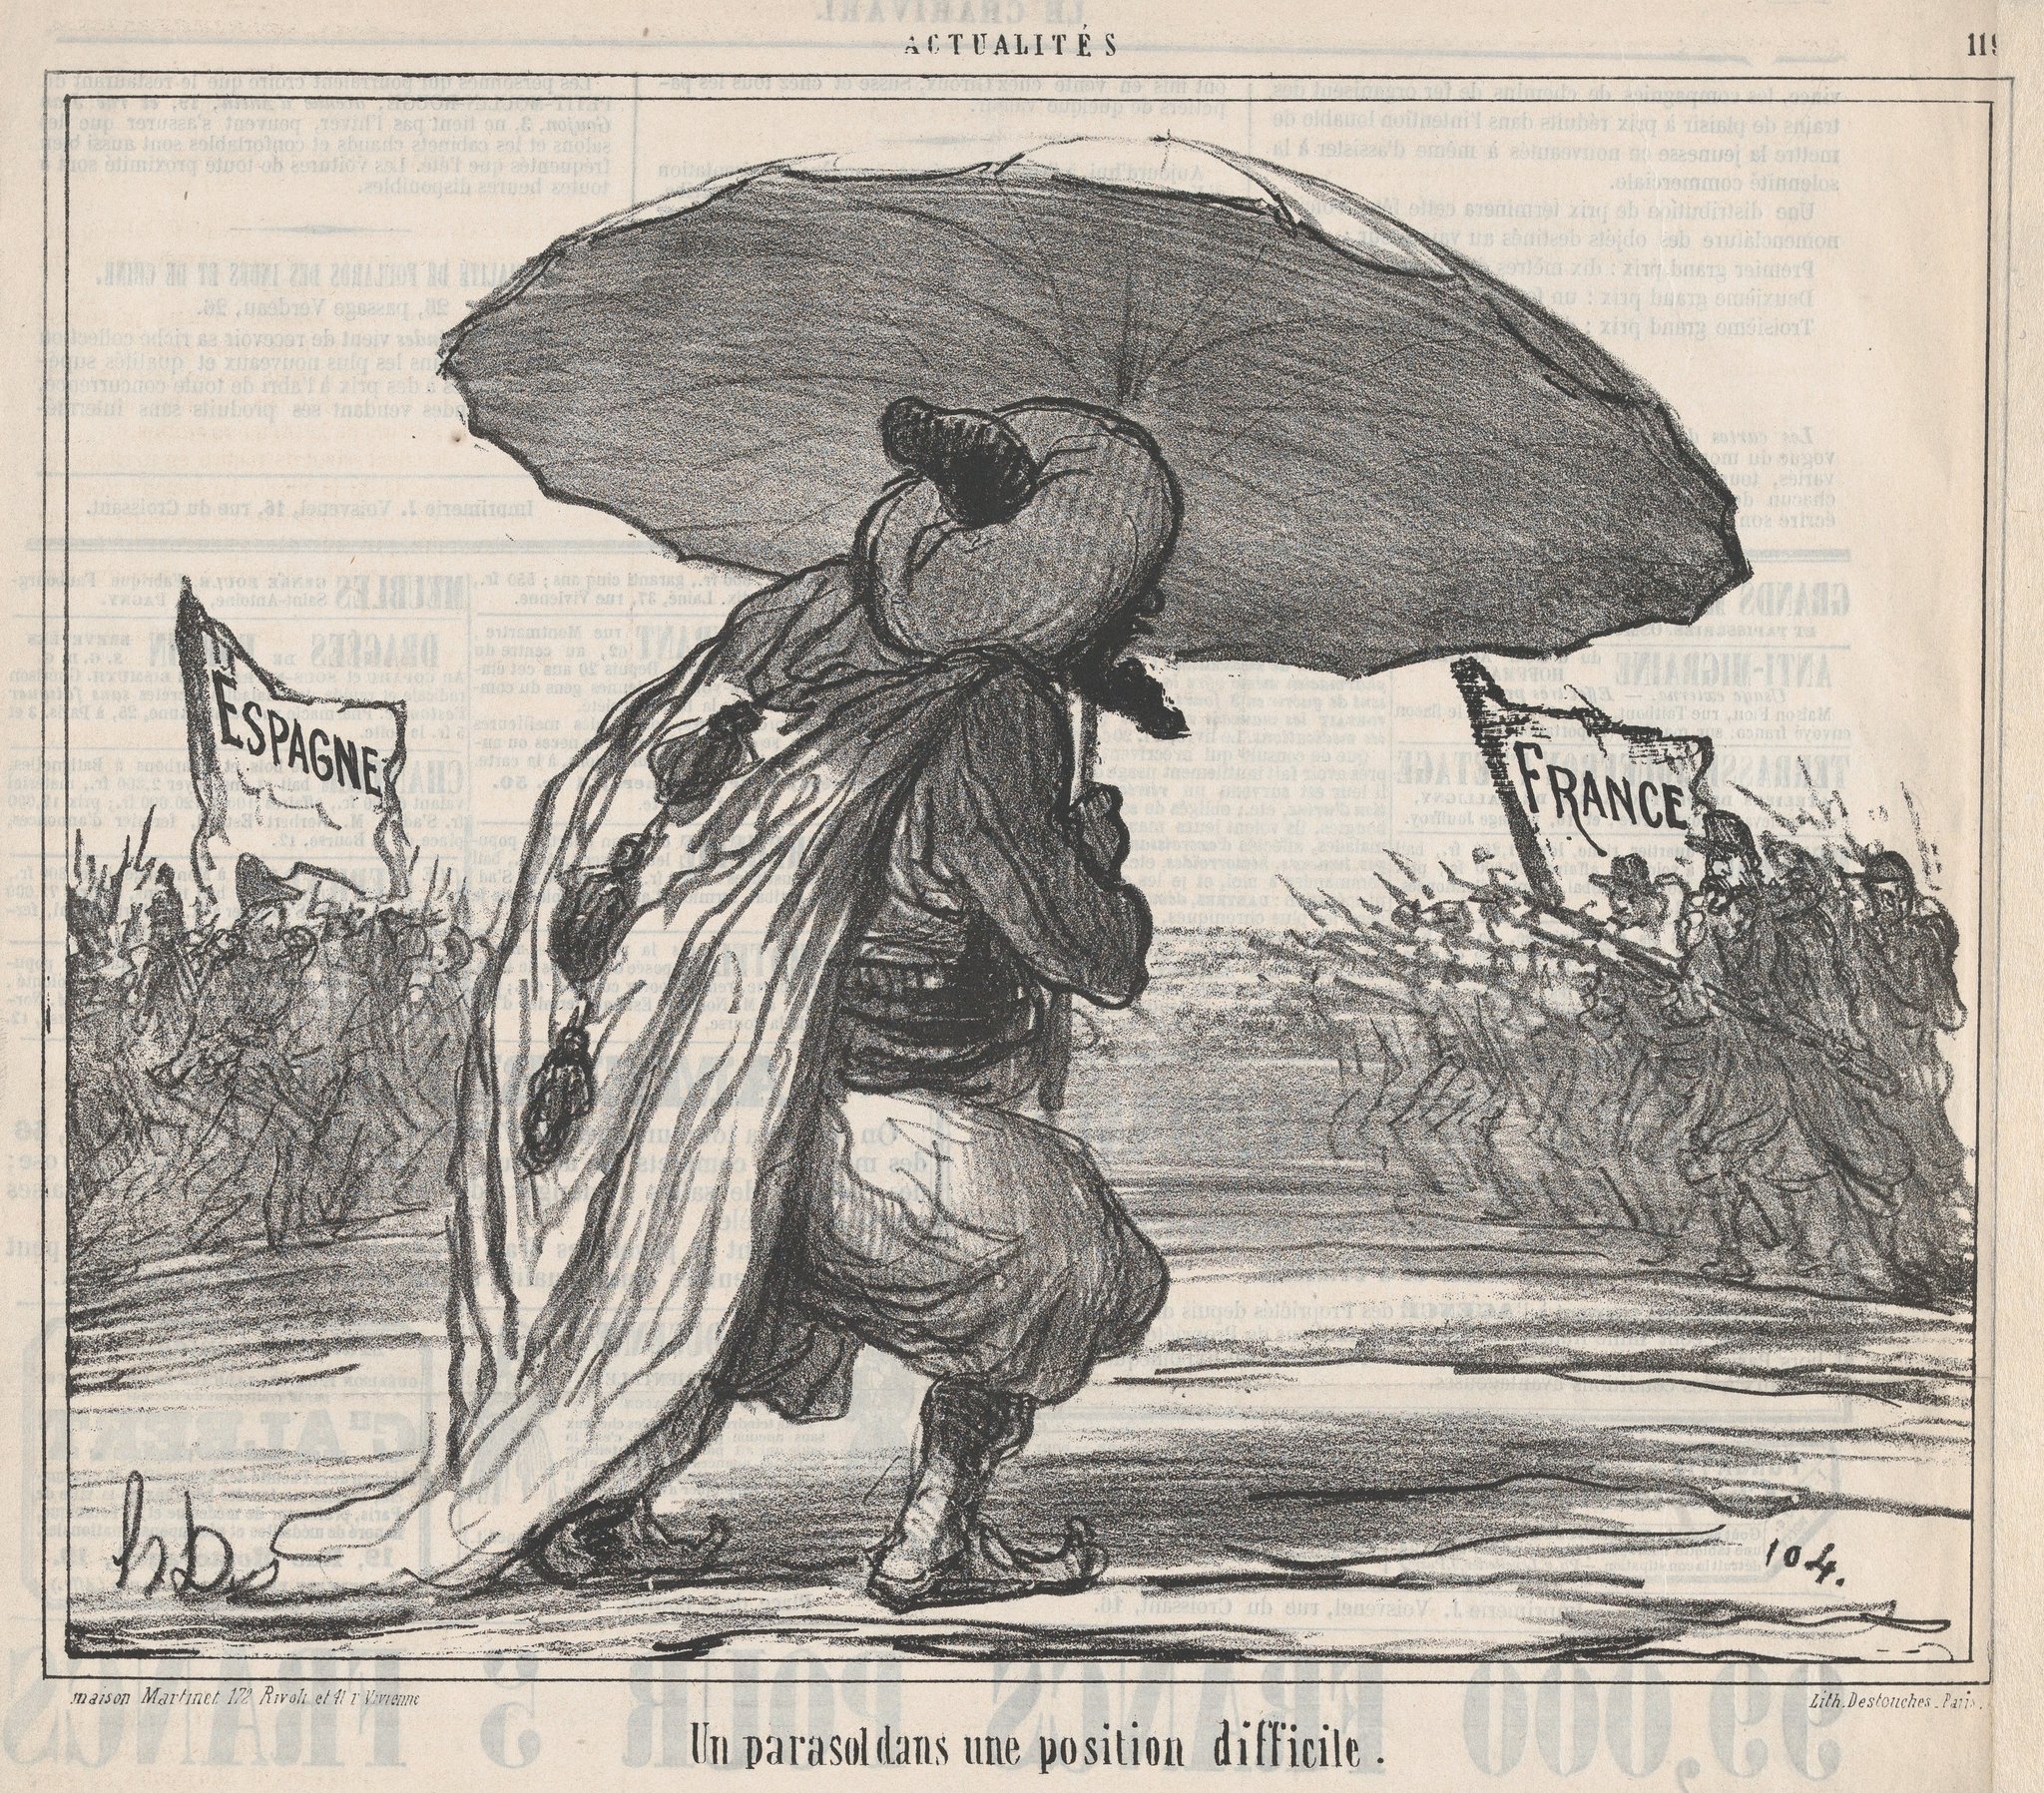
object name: print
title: Un parasol dans une position difficule, from "Actualités"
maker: honoré daumier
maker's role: artist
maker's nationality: french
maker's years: 1808-1879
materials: paper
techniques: lithograph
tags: satire,men,umbrellas